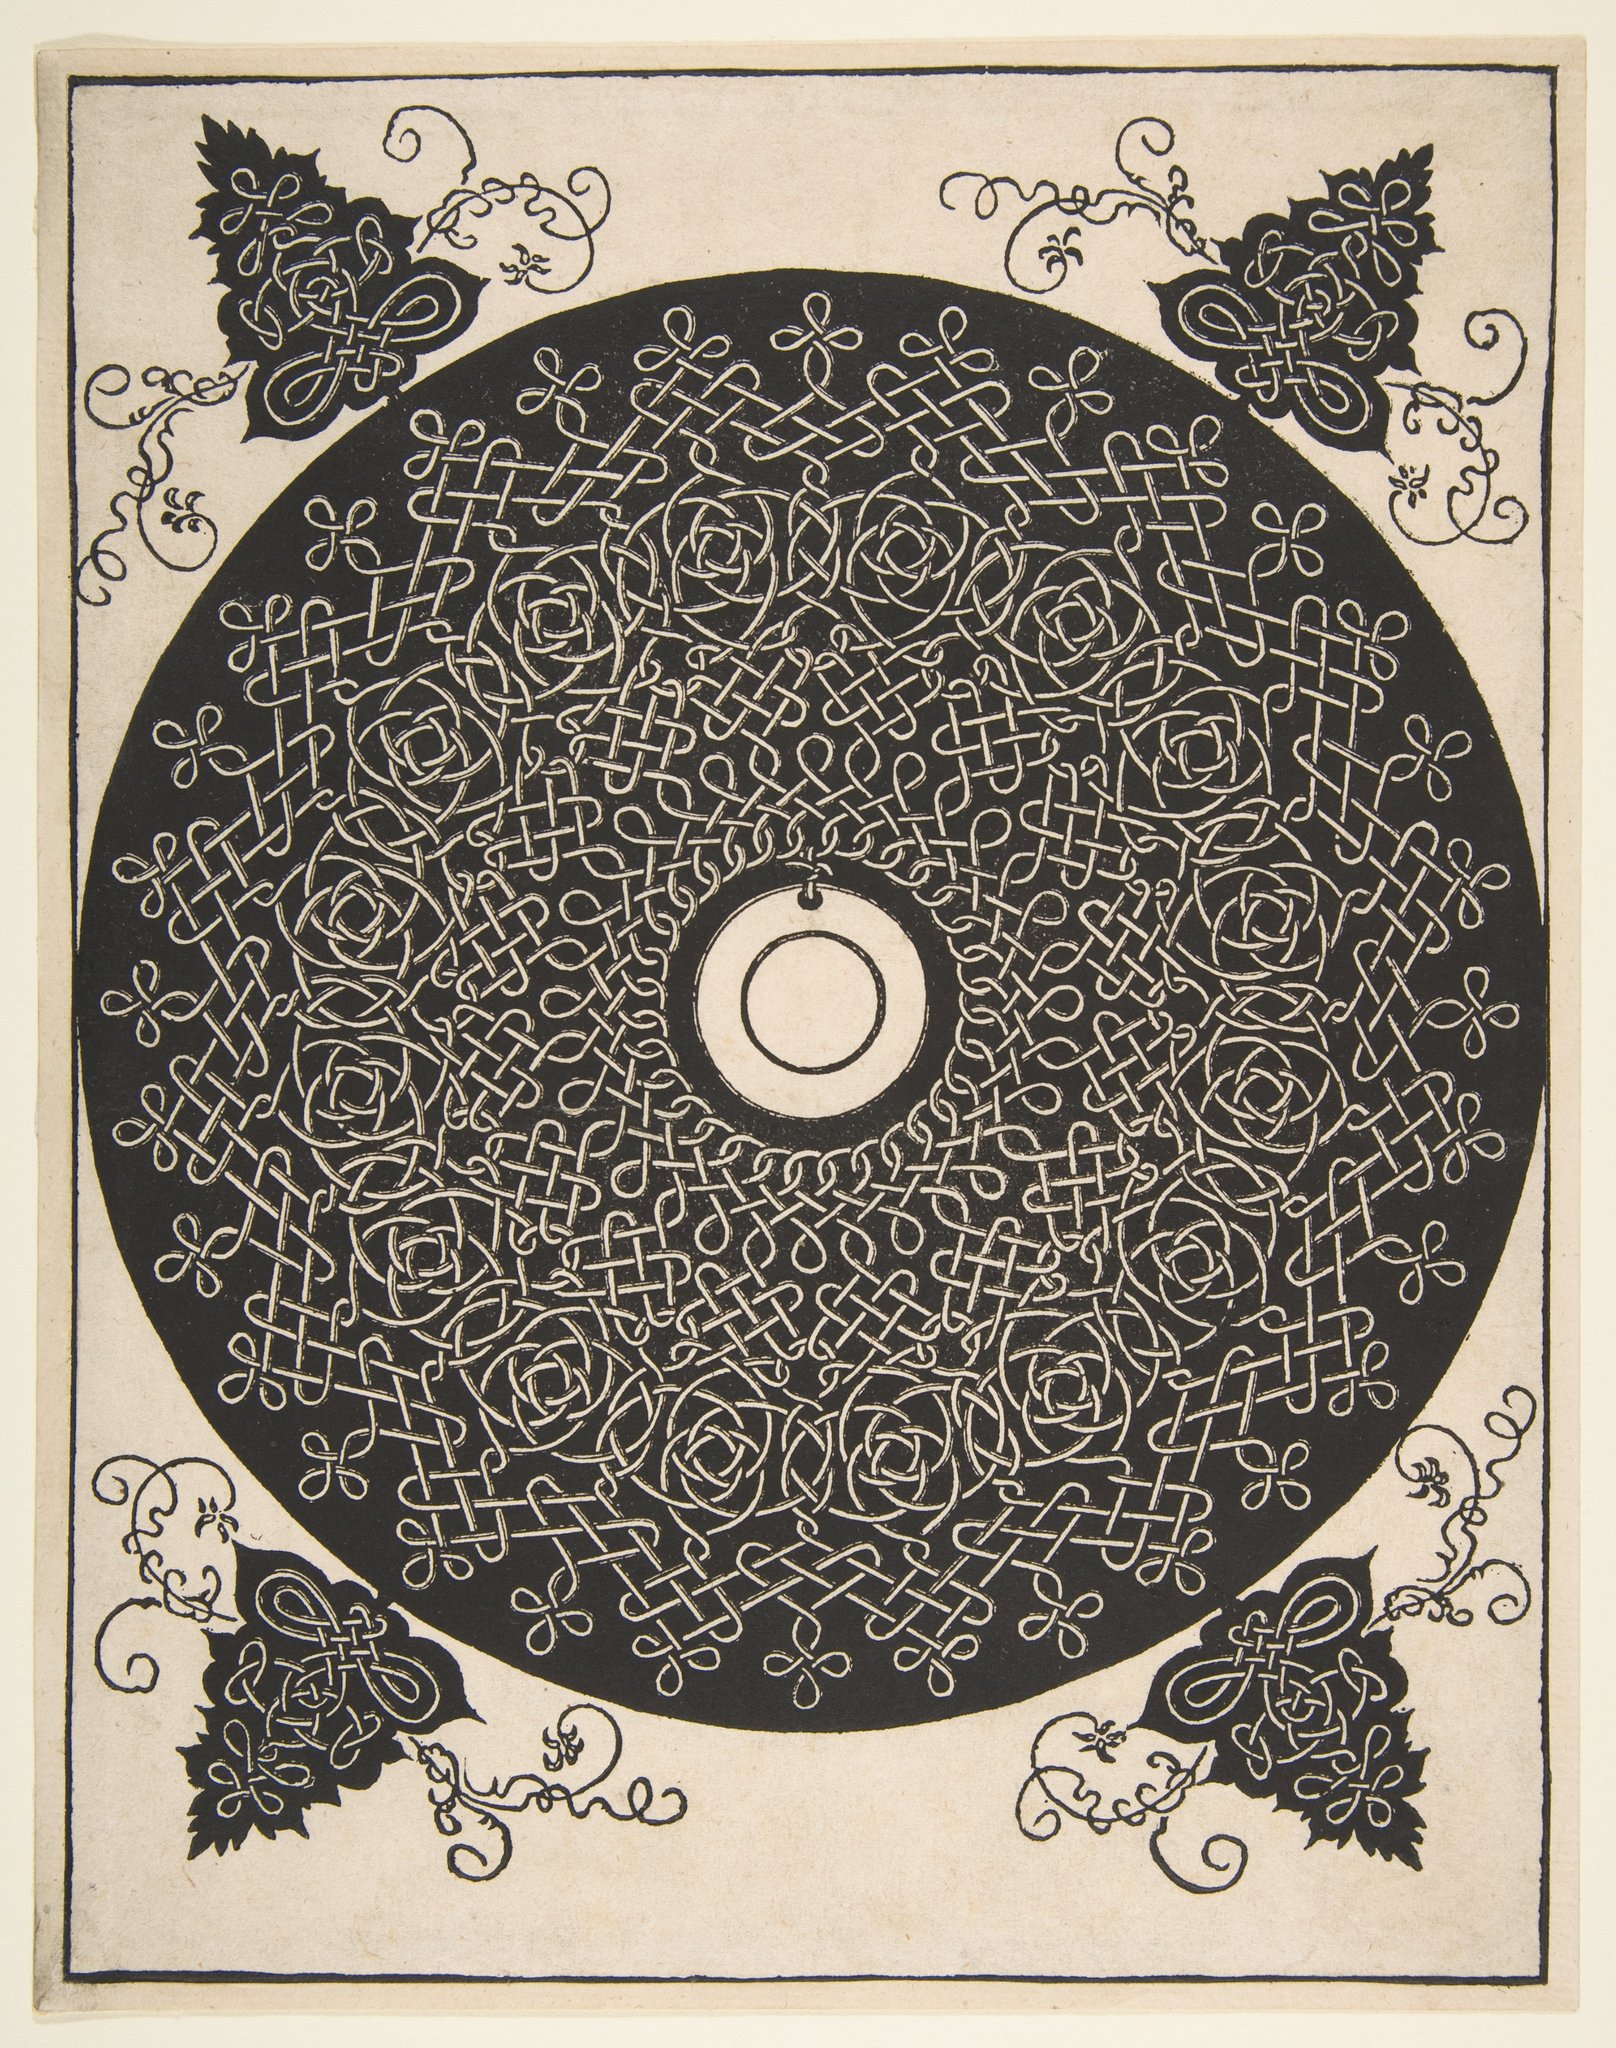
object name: collection ornament architecture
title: Embroidery Pattern with Round Medallion in its Center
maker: albrecht dürer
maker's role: artist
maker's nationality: german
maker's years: 1471-1528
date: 1521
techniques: woodcut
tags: ornament